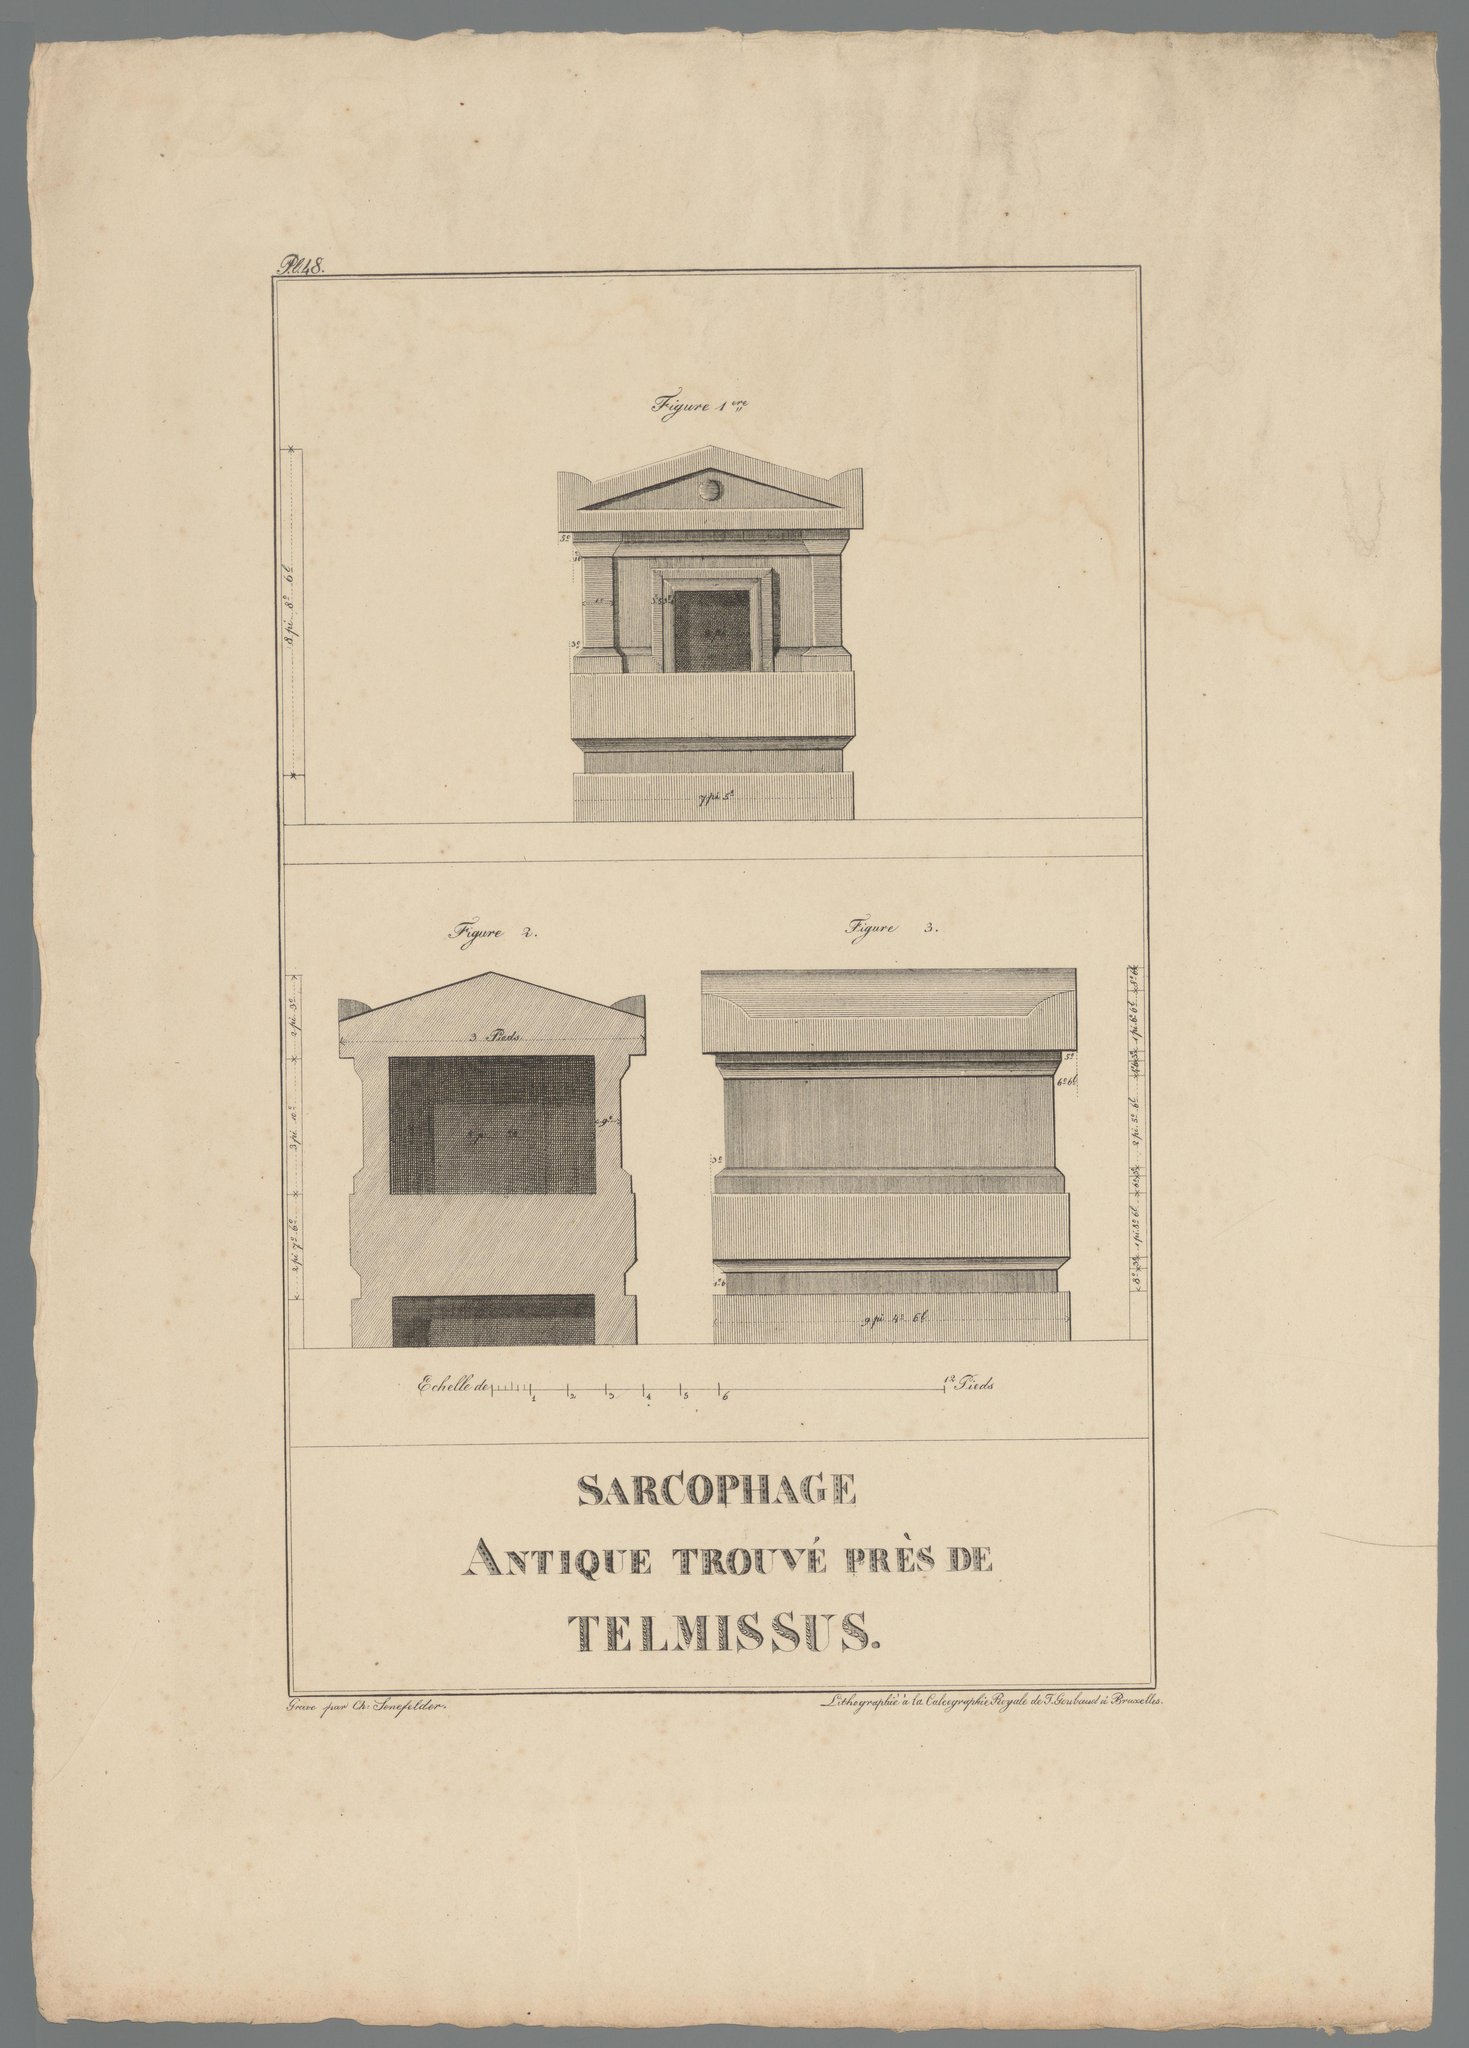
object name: print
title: Sarcophage Antique trouvé près de Telmissus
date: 1810-1836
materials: paper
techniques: lithograph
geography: brussels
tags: sarcophagus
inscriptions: collector's mark: Lugt 2228